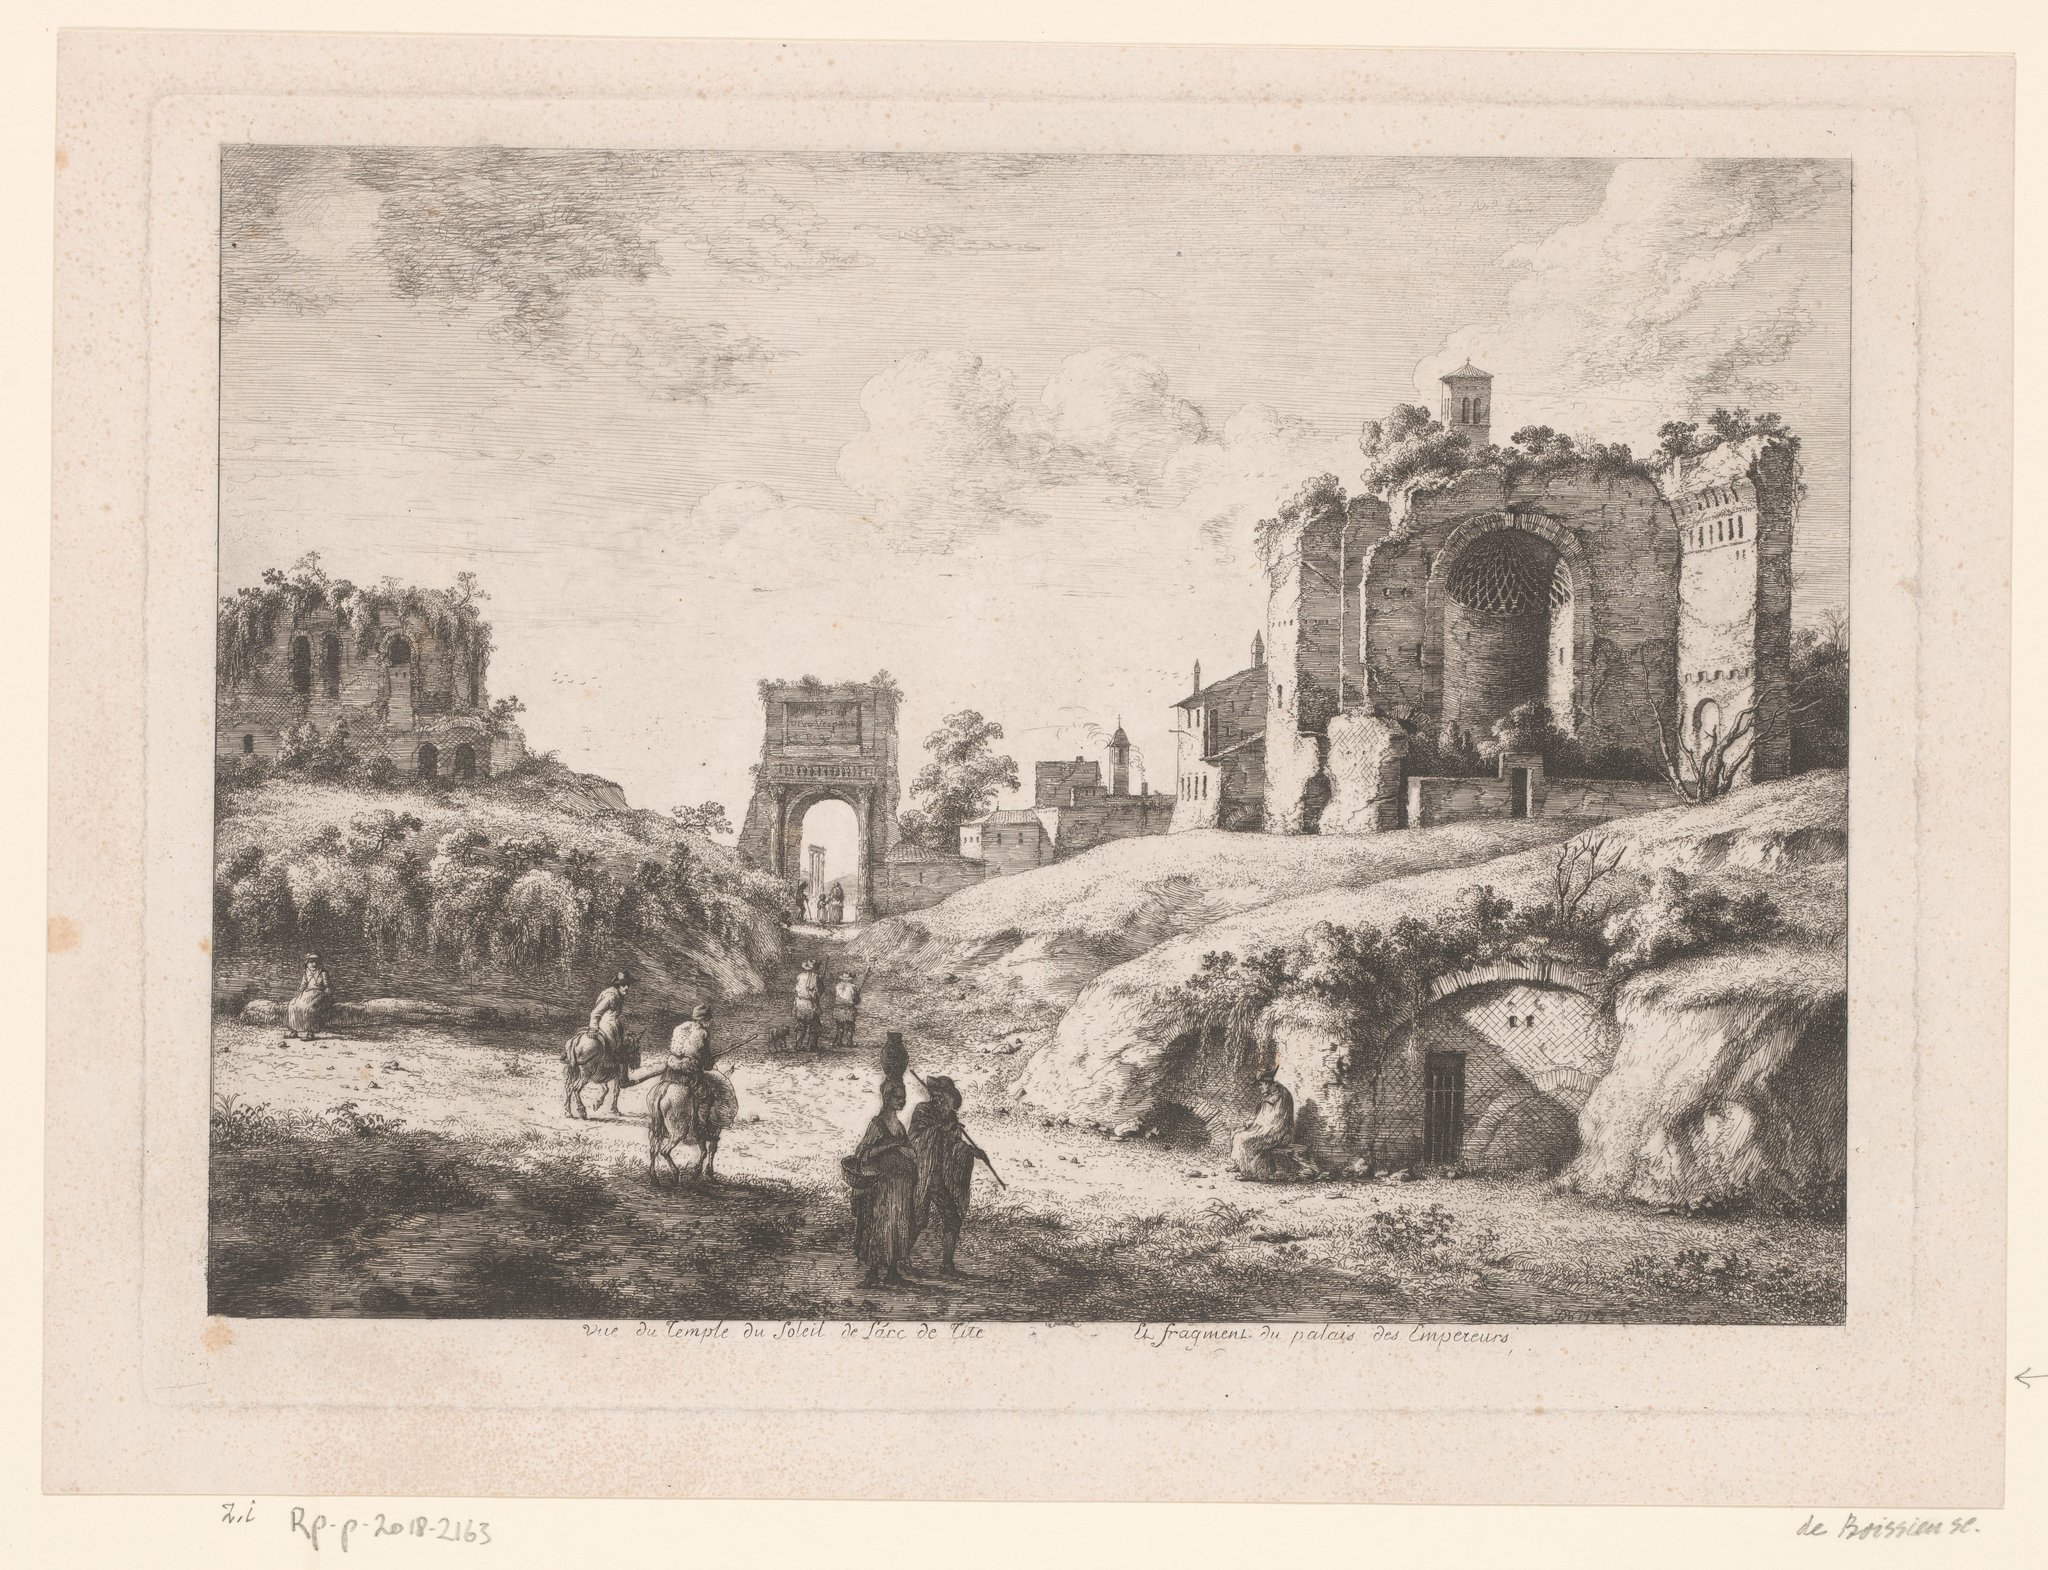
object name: print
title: Gezicht op de Boog van Titus en andere ruïnes op het Forum Romanum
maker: jean jacques de boissieu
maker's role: draughtsman, print maker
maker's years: 1736-1810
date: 1773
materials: paper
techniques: etching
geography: france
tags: triumphal arch, landscape with ruins - ii - ideal landscapes, rome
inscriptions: date